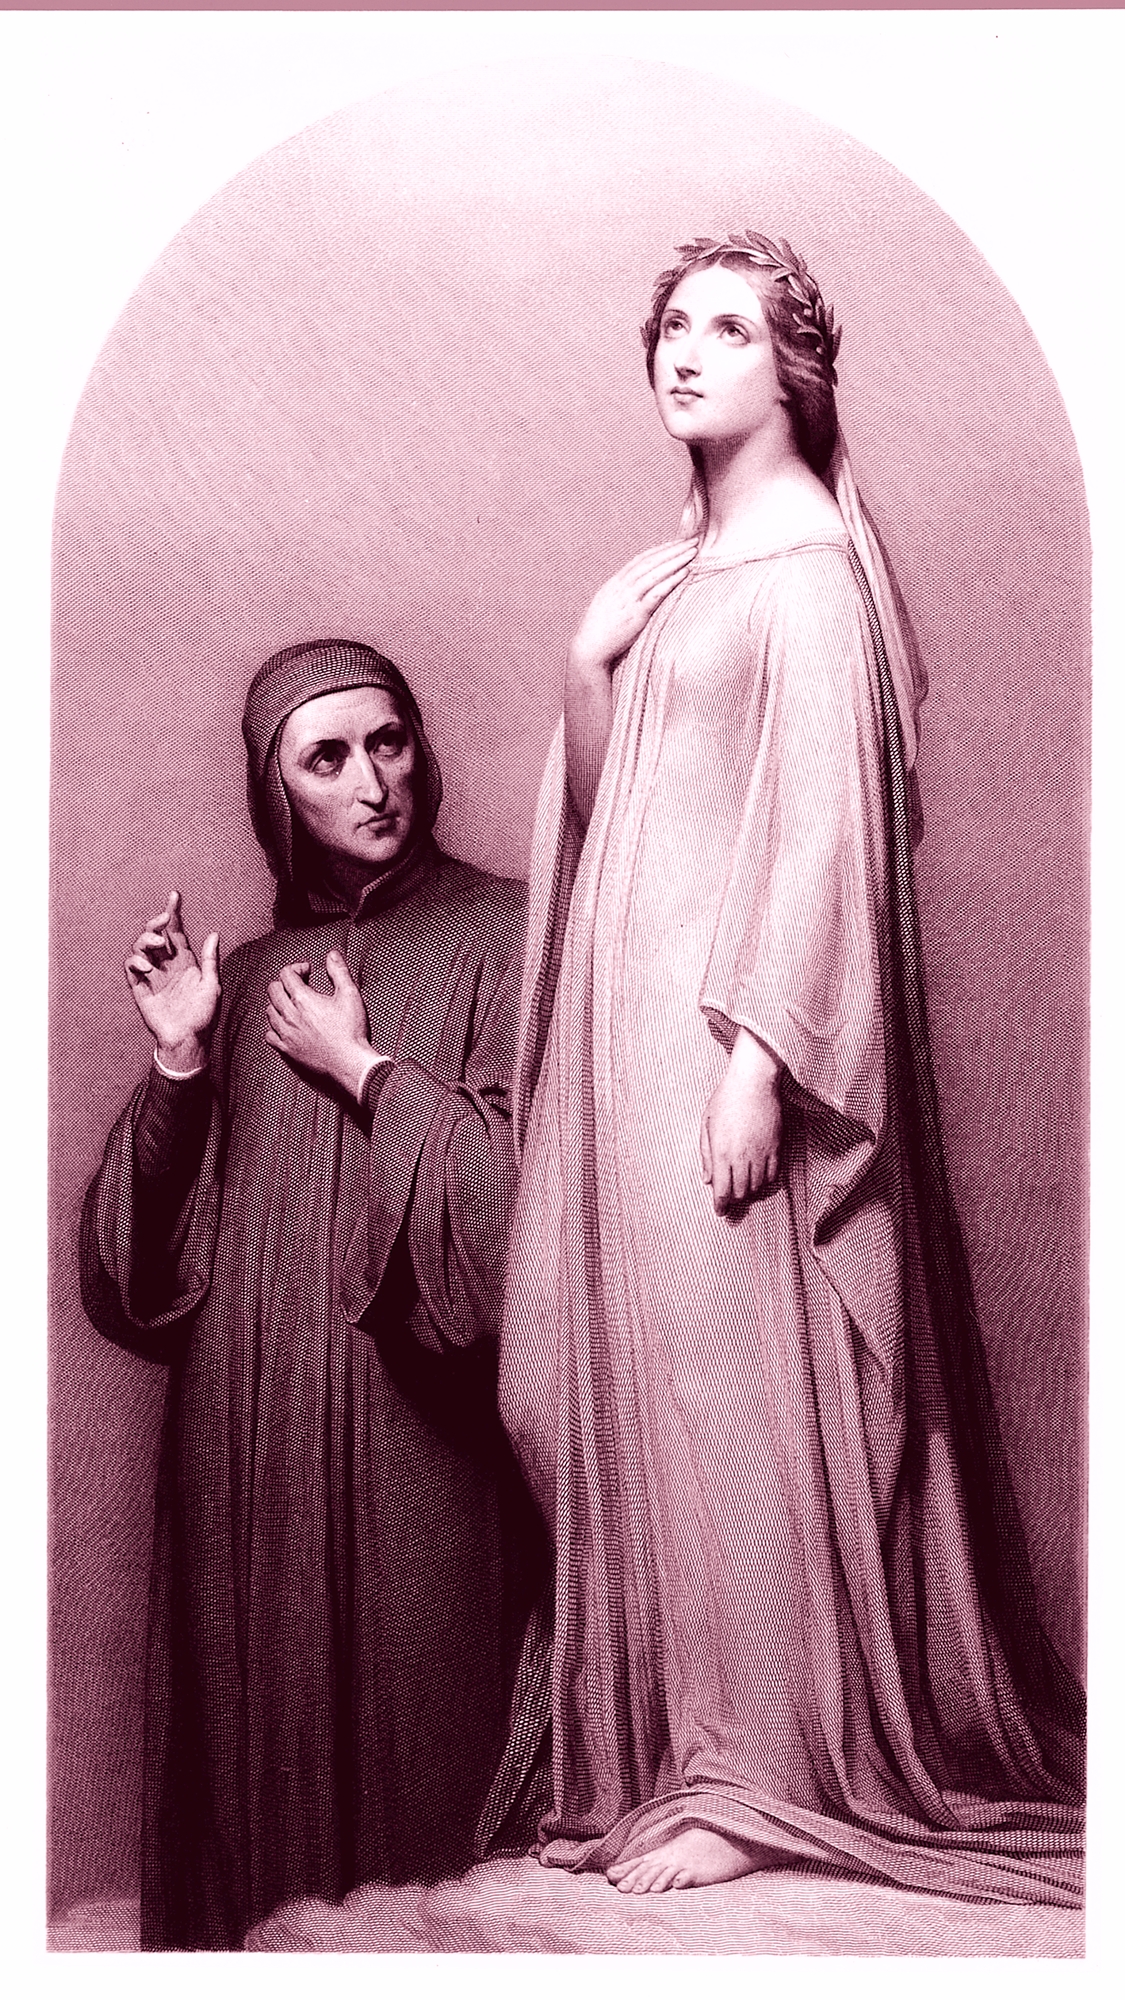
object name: print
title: Dante and Beatrice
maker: narcisse lecomte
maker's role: artist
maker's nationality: french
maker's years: 1794-1882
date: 1801-1900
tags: men,women